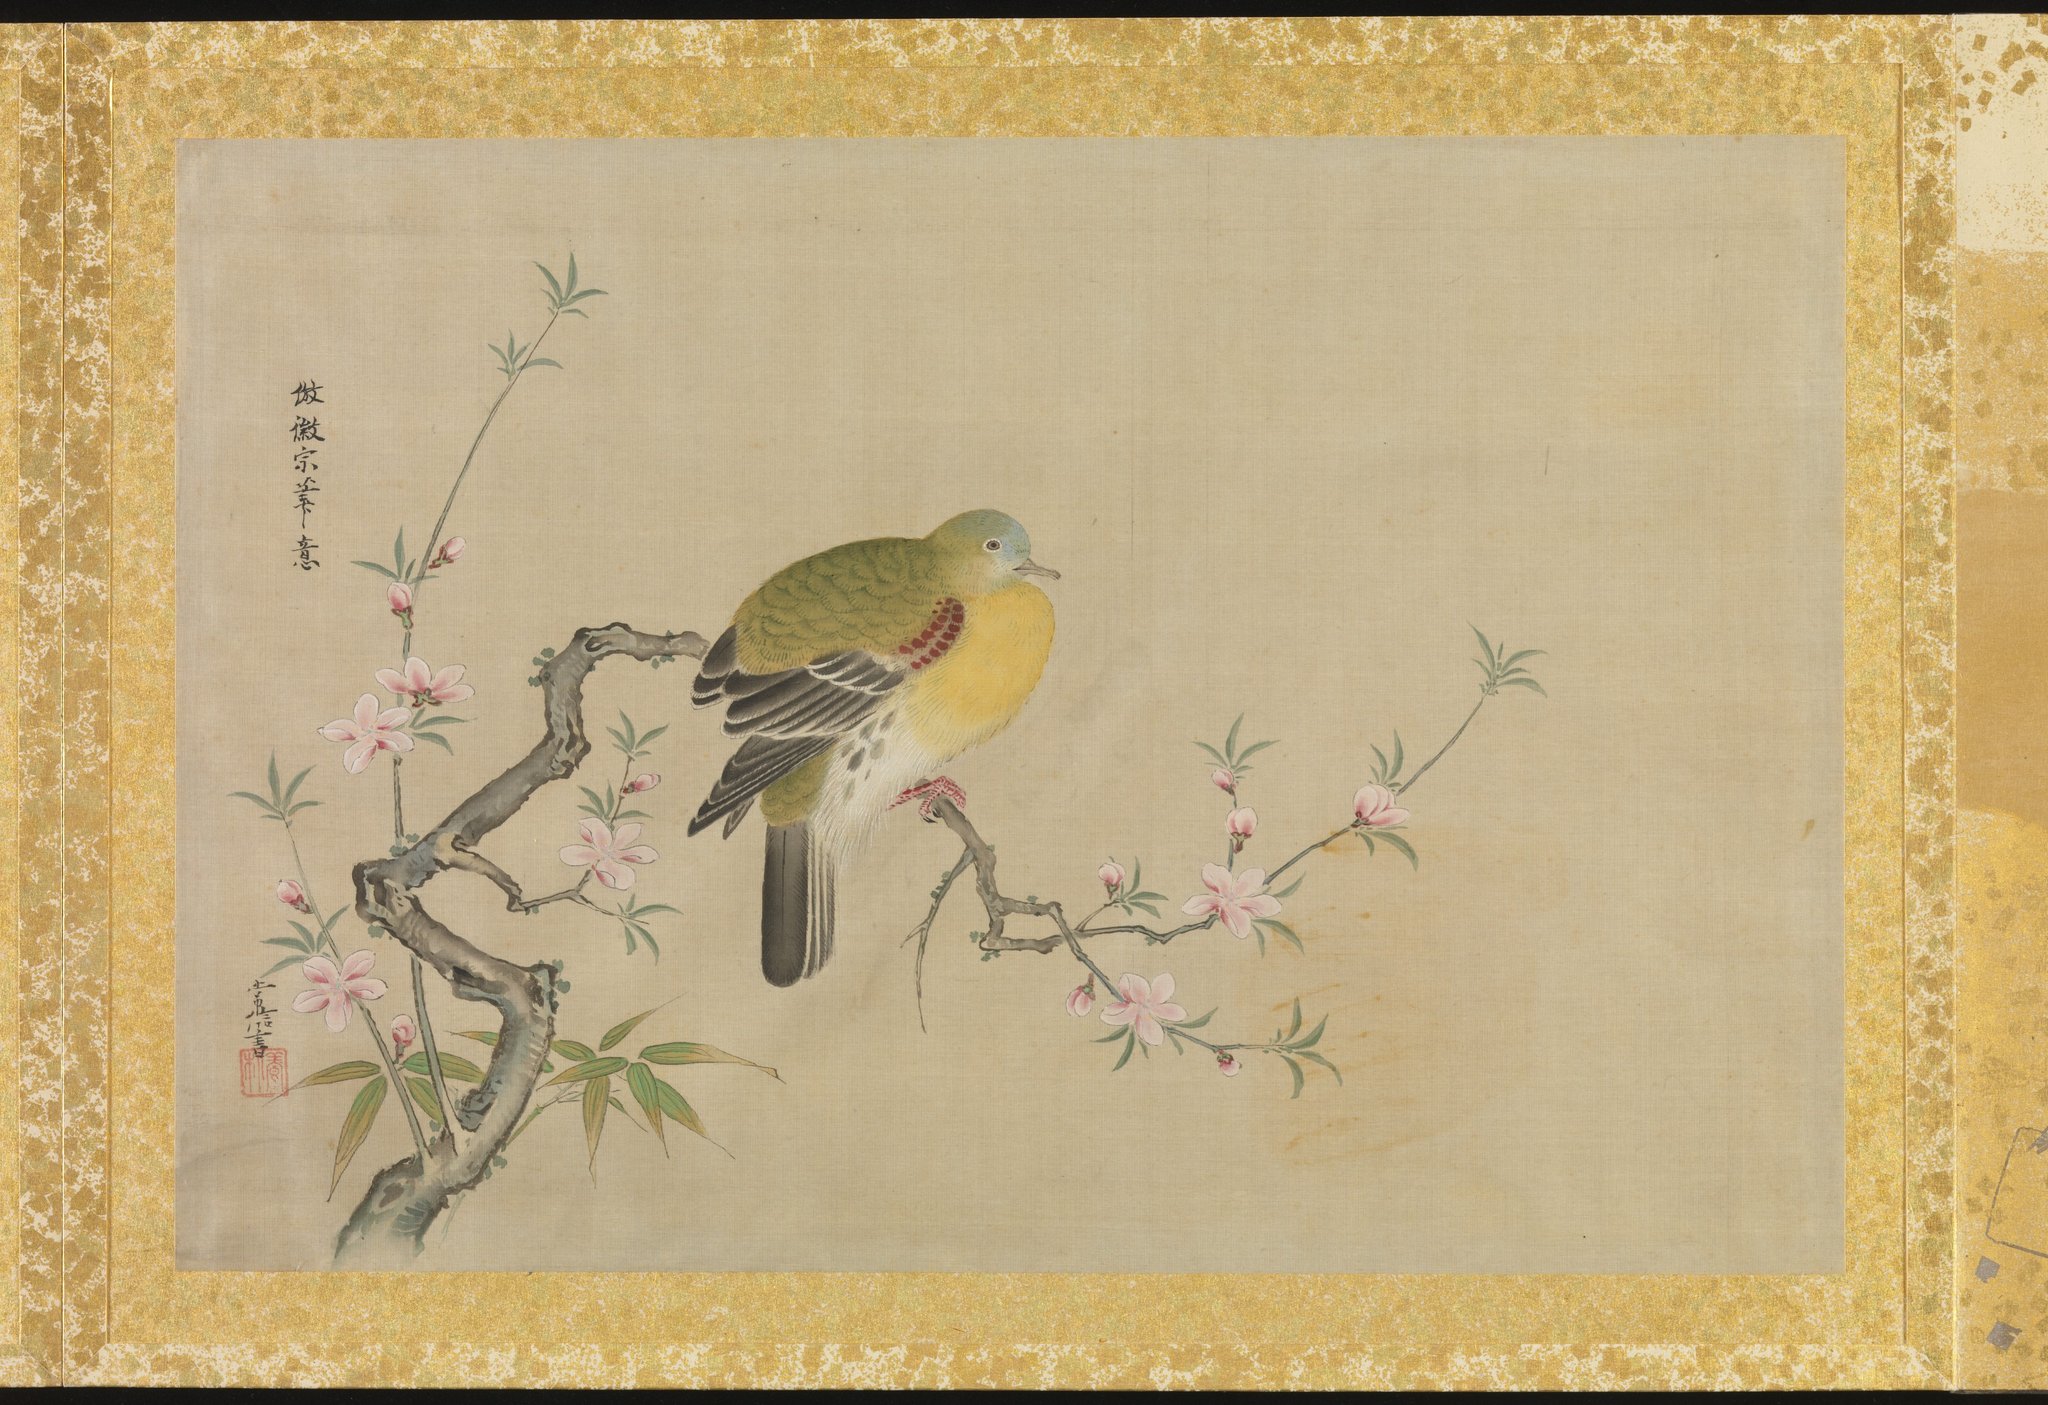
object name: album leaf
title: Album of Copies of Chinese Paintings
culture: japanese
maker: kano tsunenobu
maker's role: artist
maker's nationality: japanese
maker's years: 1636-1713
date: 1601-1700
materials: ink, silk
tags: birds,flowers